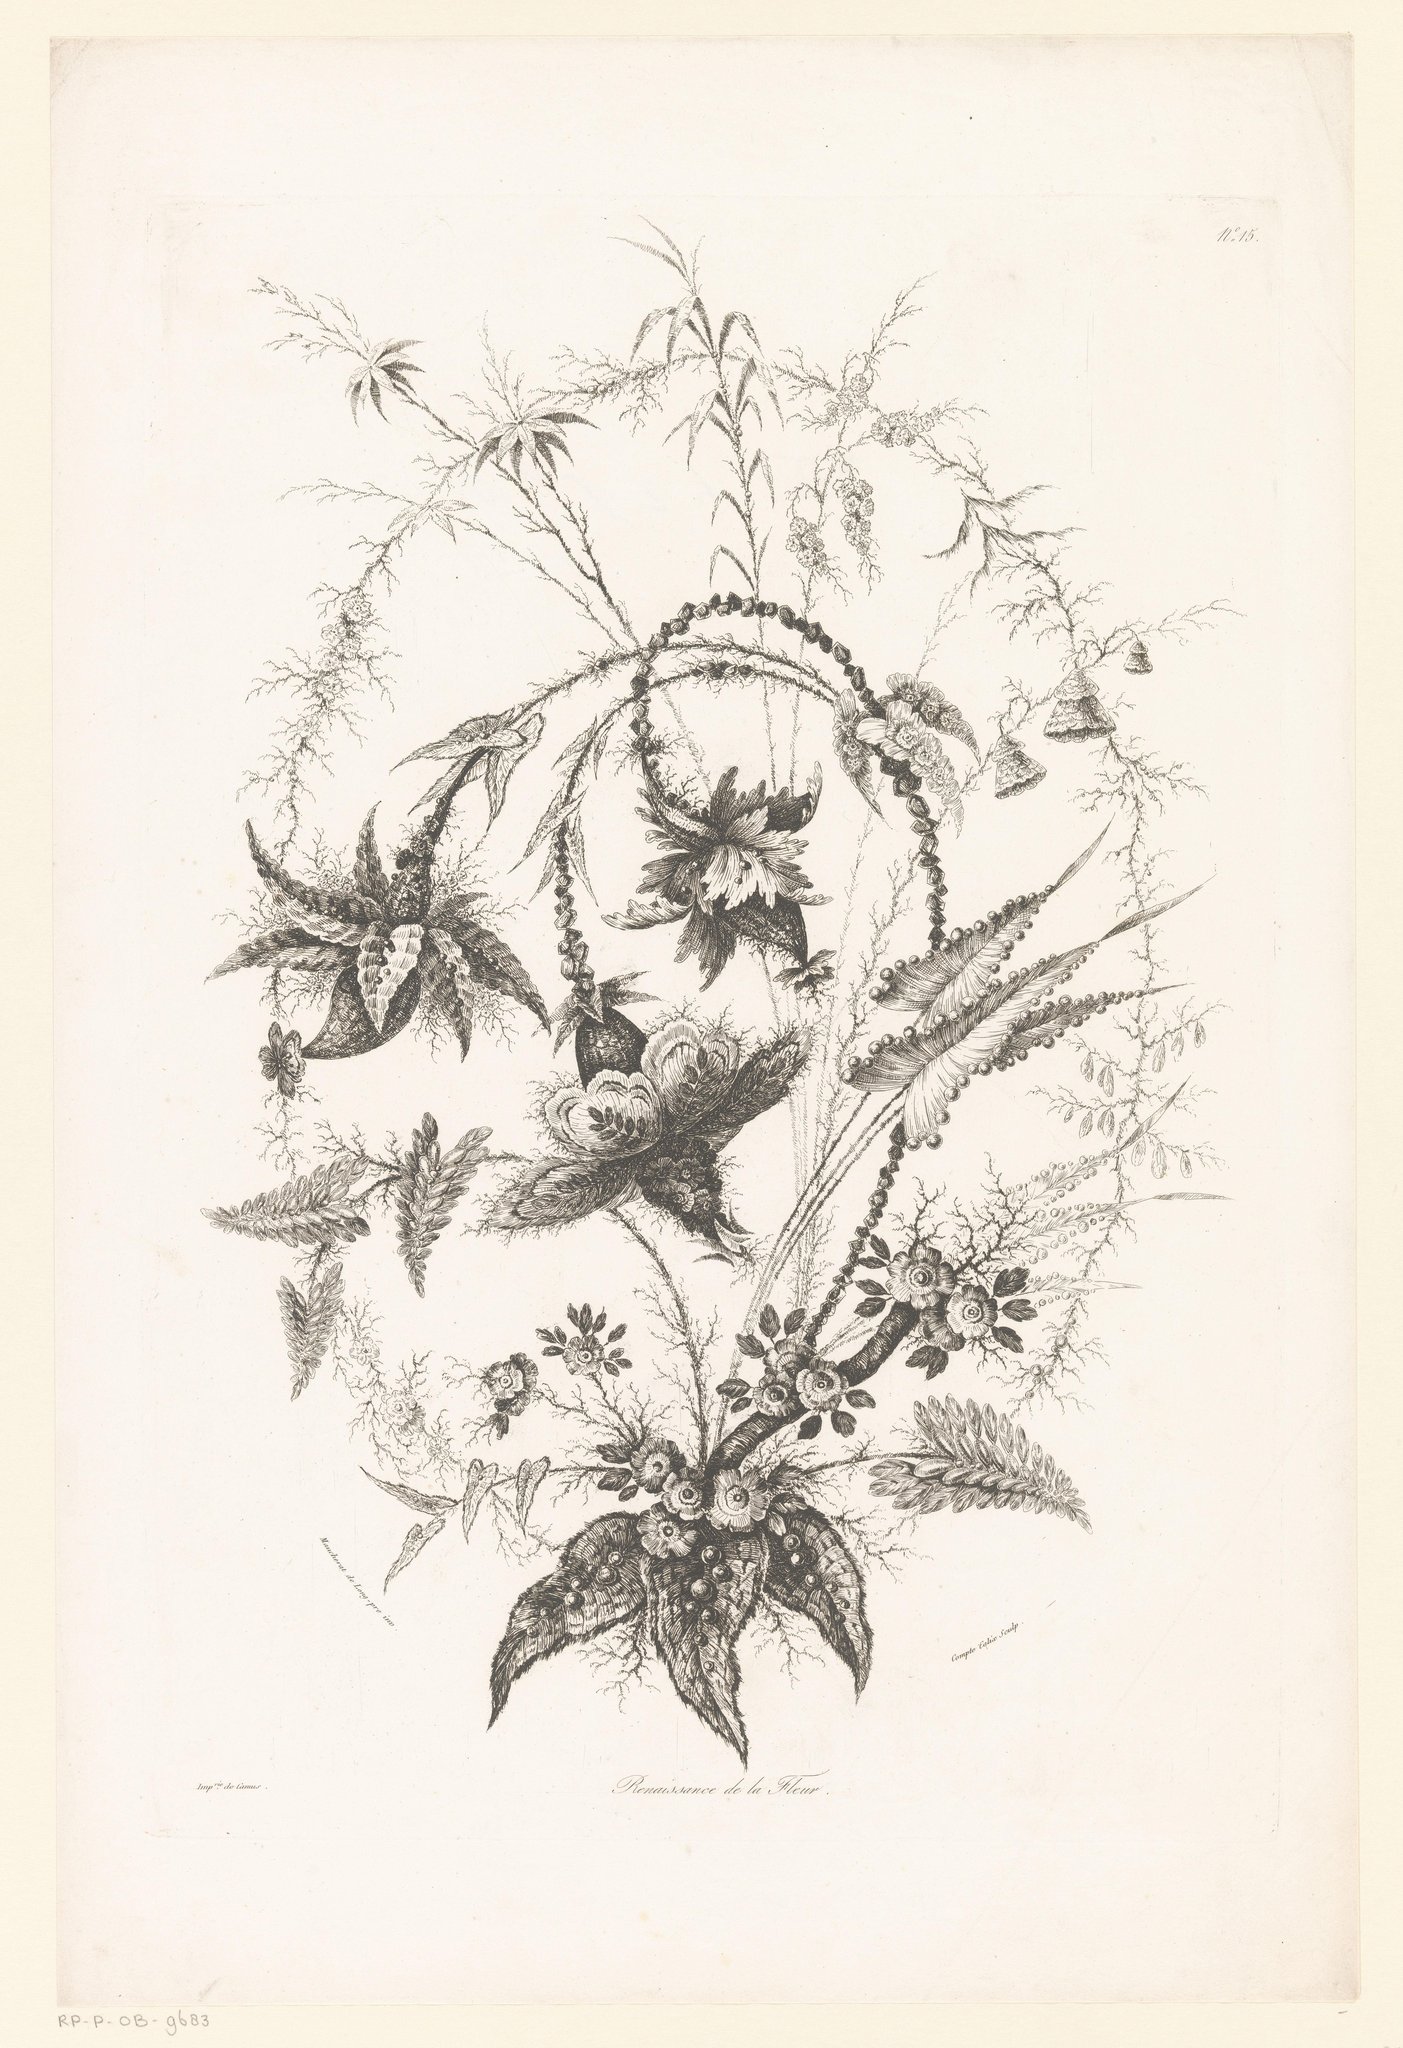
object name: print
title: Renaissance de la Fleur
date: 1829-1839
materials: paper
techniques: etching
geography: paris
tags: flowers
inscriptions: collector's mark: Lugt 2228, collector's mark: Lugt 3937